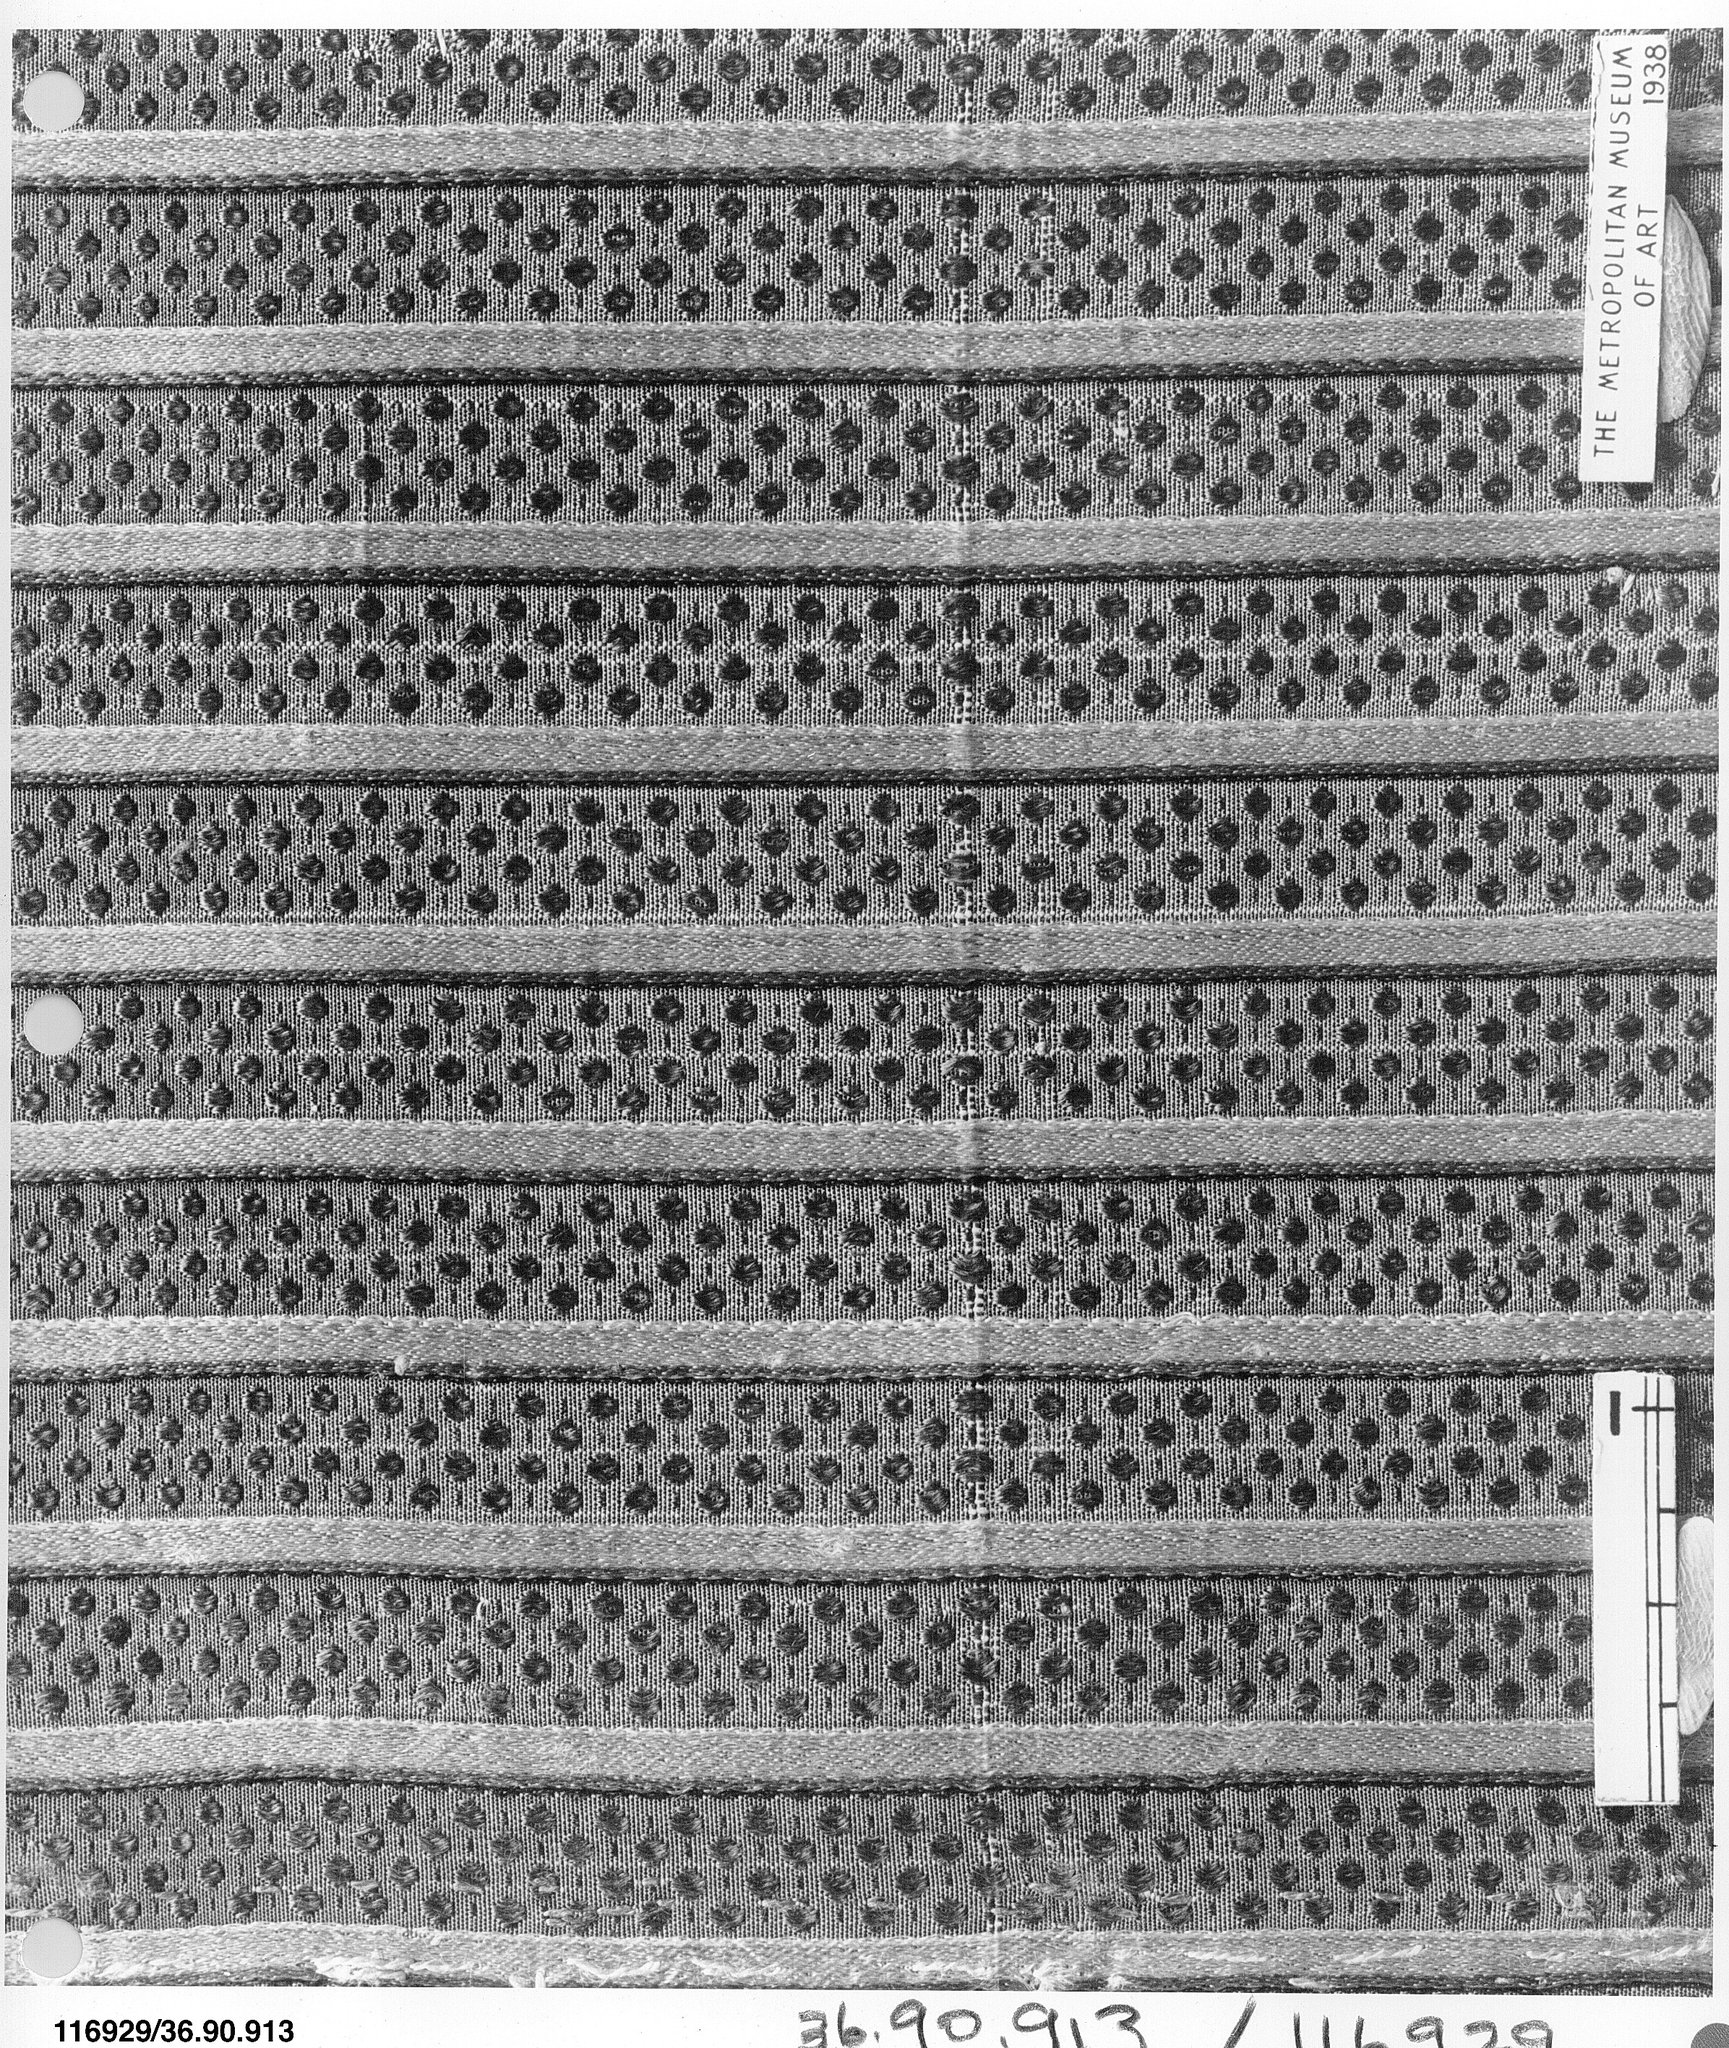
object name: piece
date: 1701-1800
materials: silk